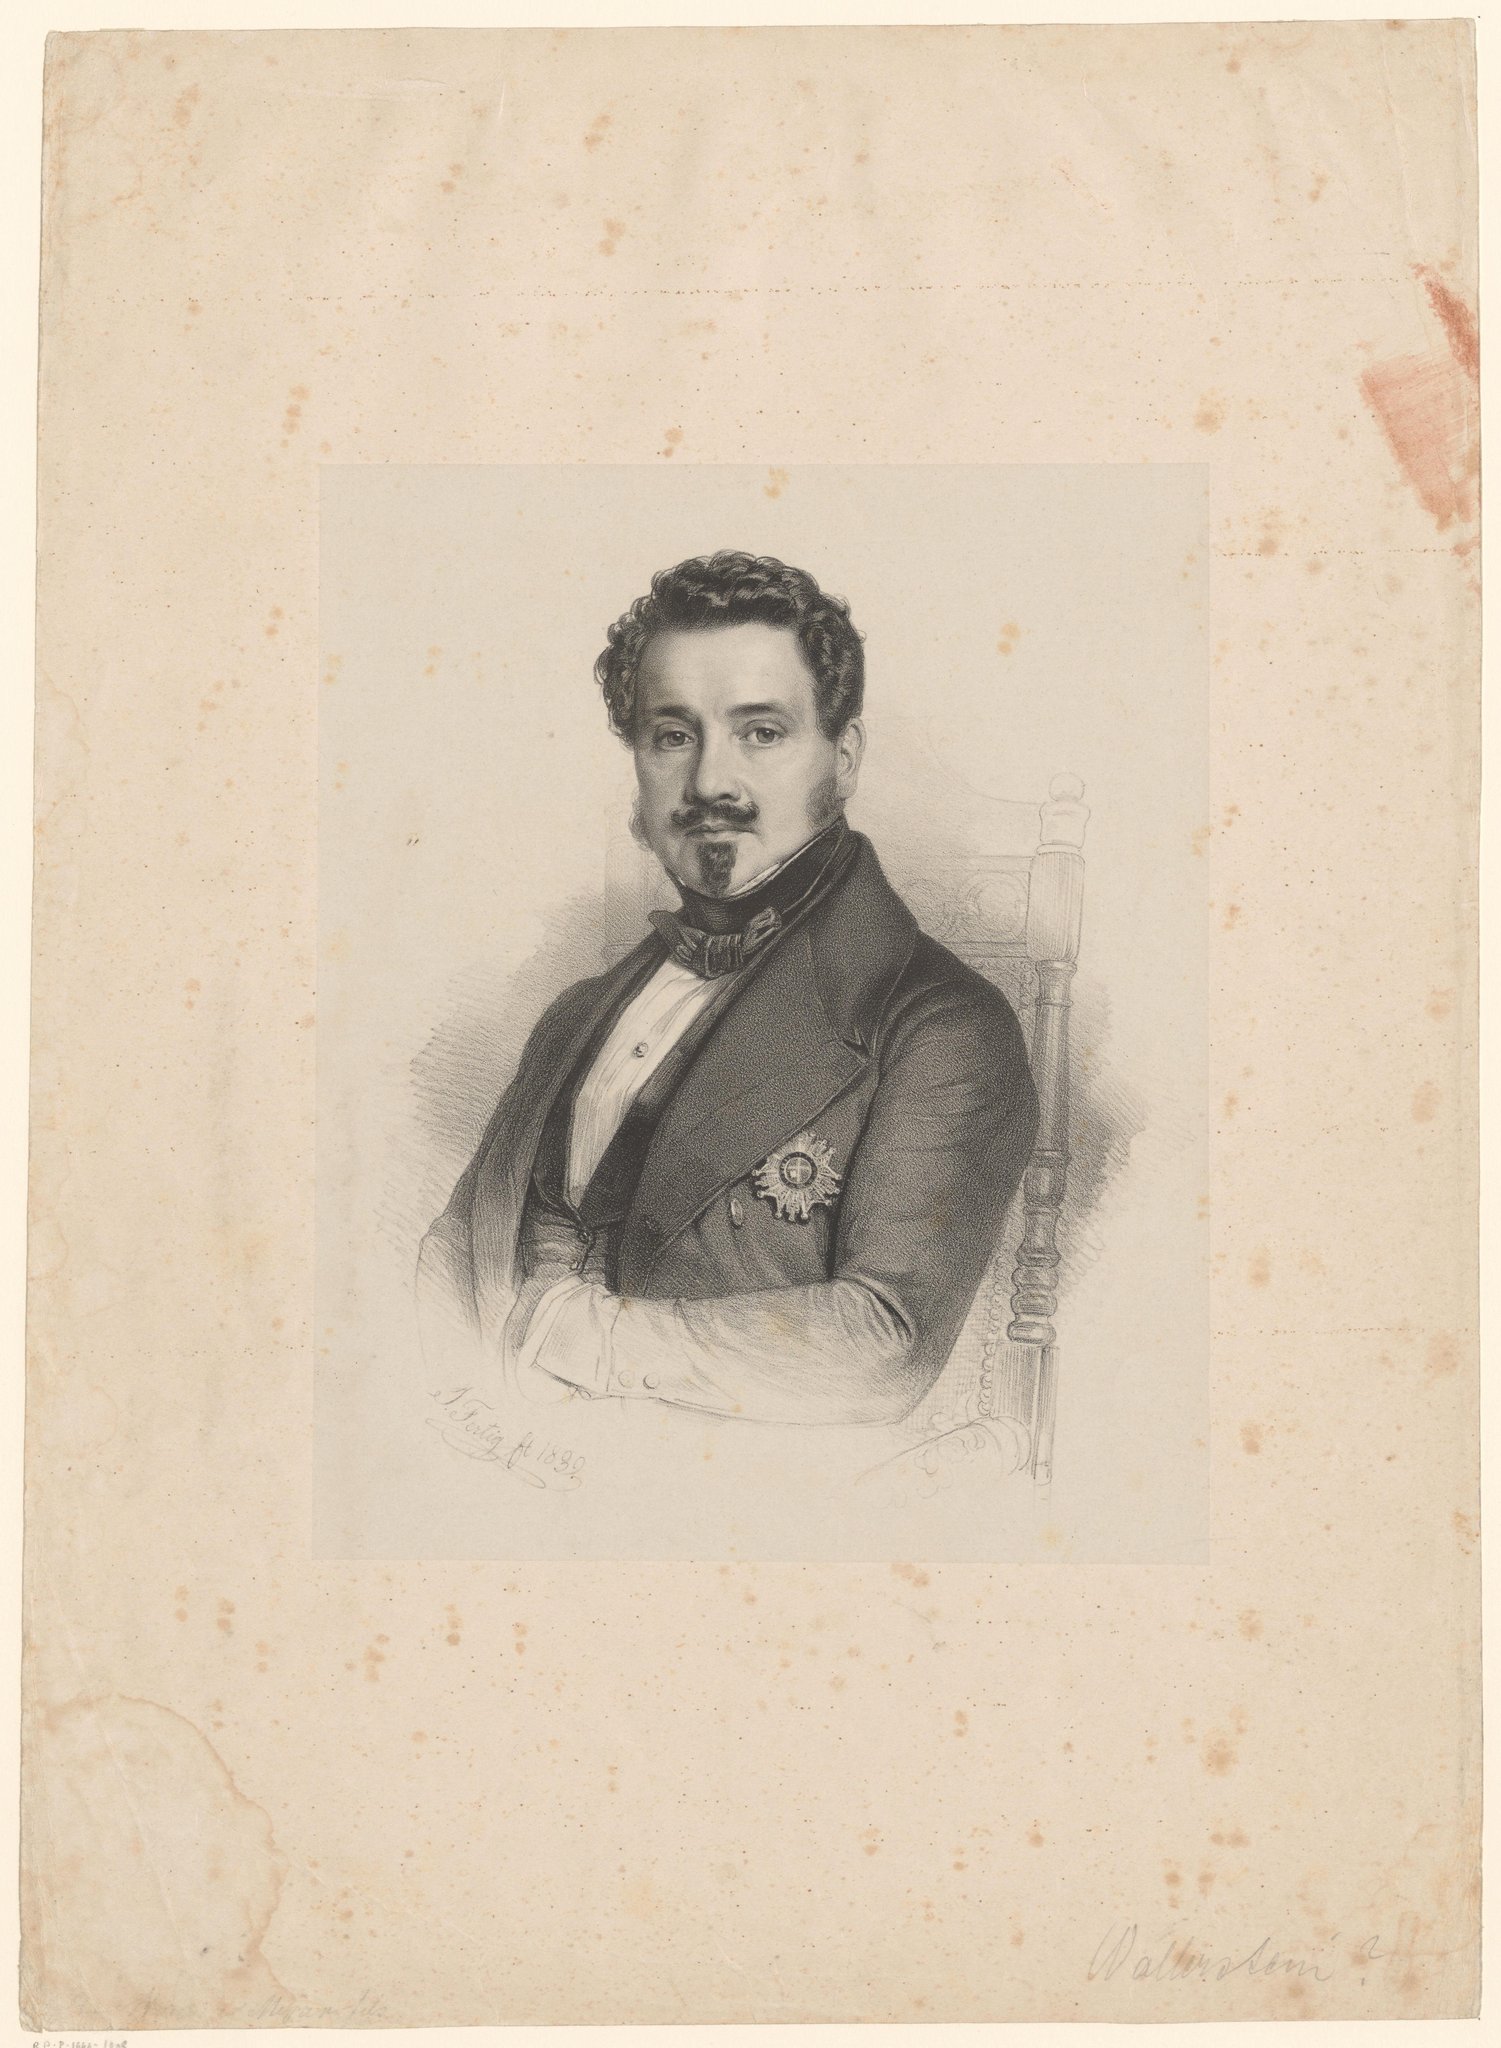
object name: print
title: Portret van een onbekende man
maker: ignaz fertig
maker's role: print maker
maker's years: 1809-1858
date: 1839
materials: paper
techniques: lithograph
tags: historical persons not known by name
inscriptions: collector's mark: Lugt 2228, collector's mark: Lugt 2760, : ‘Wallerstein?’